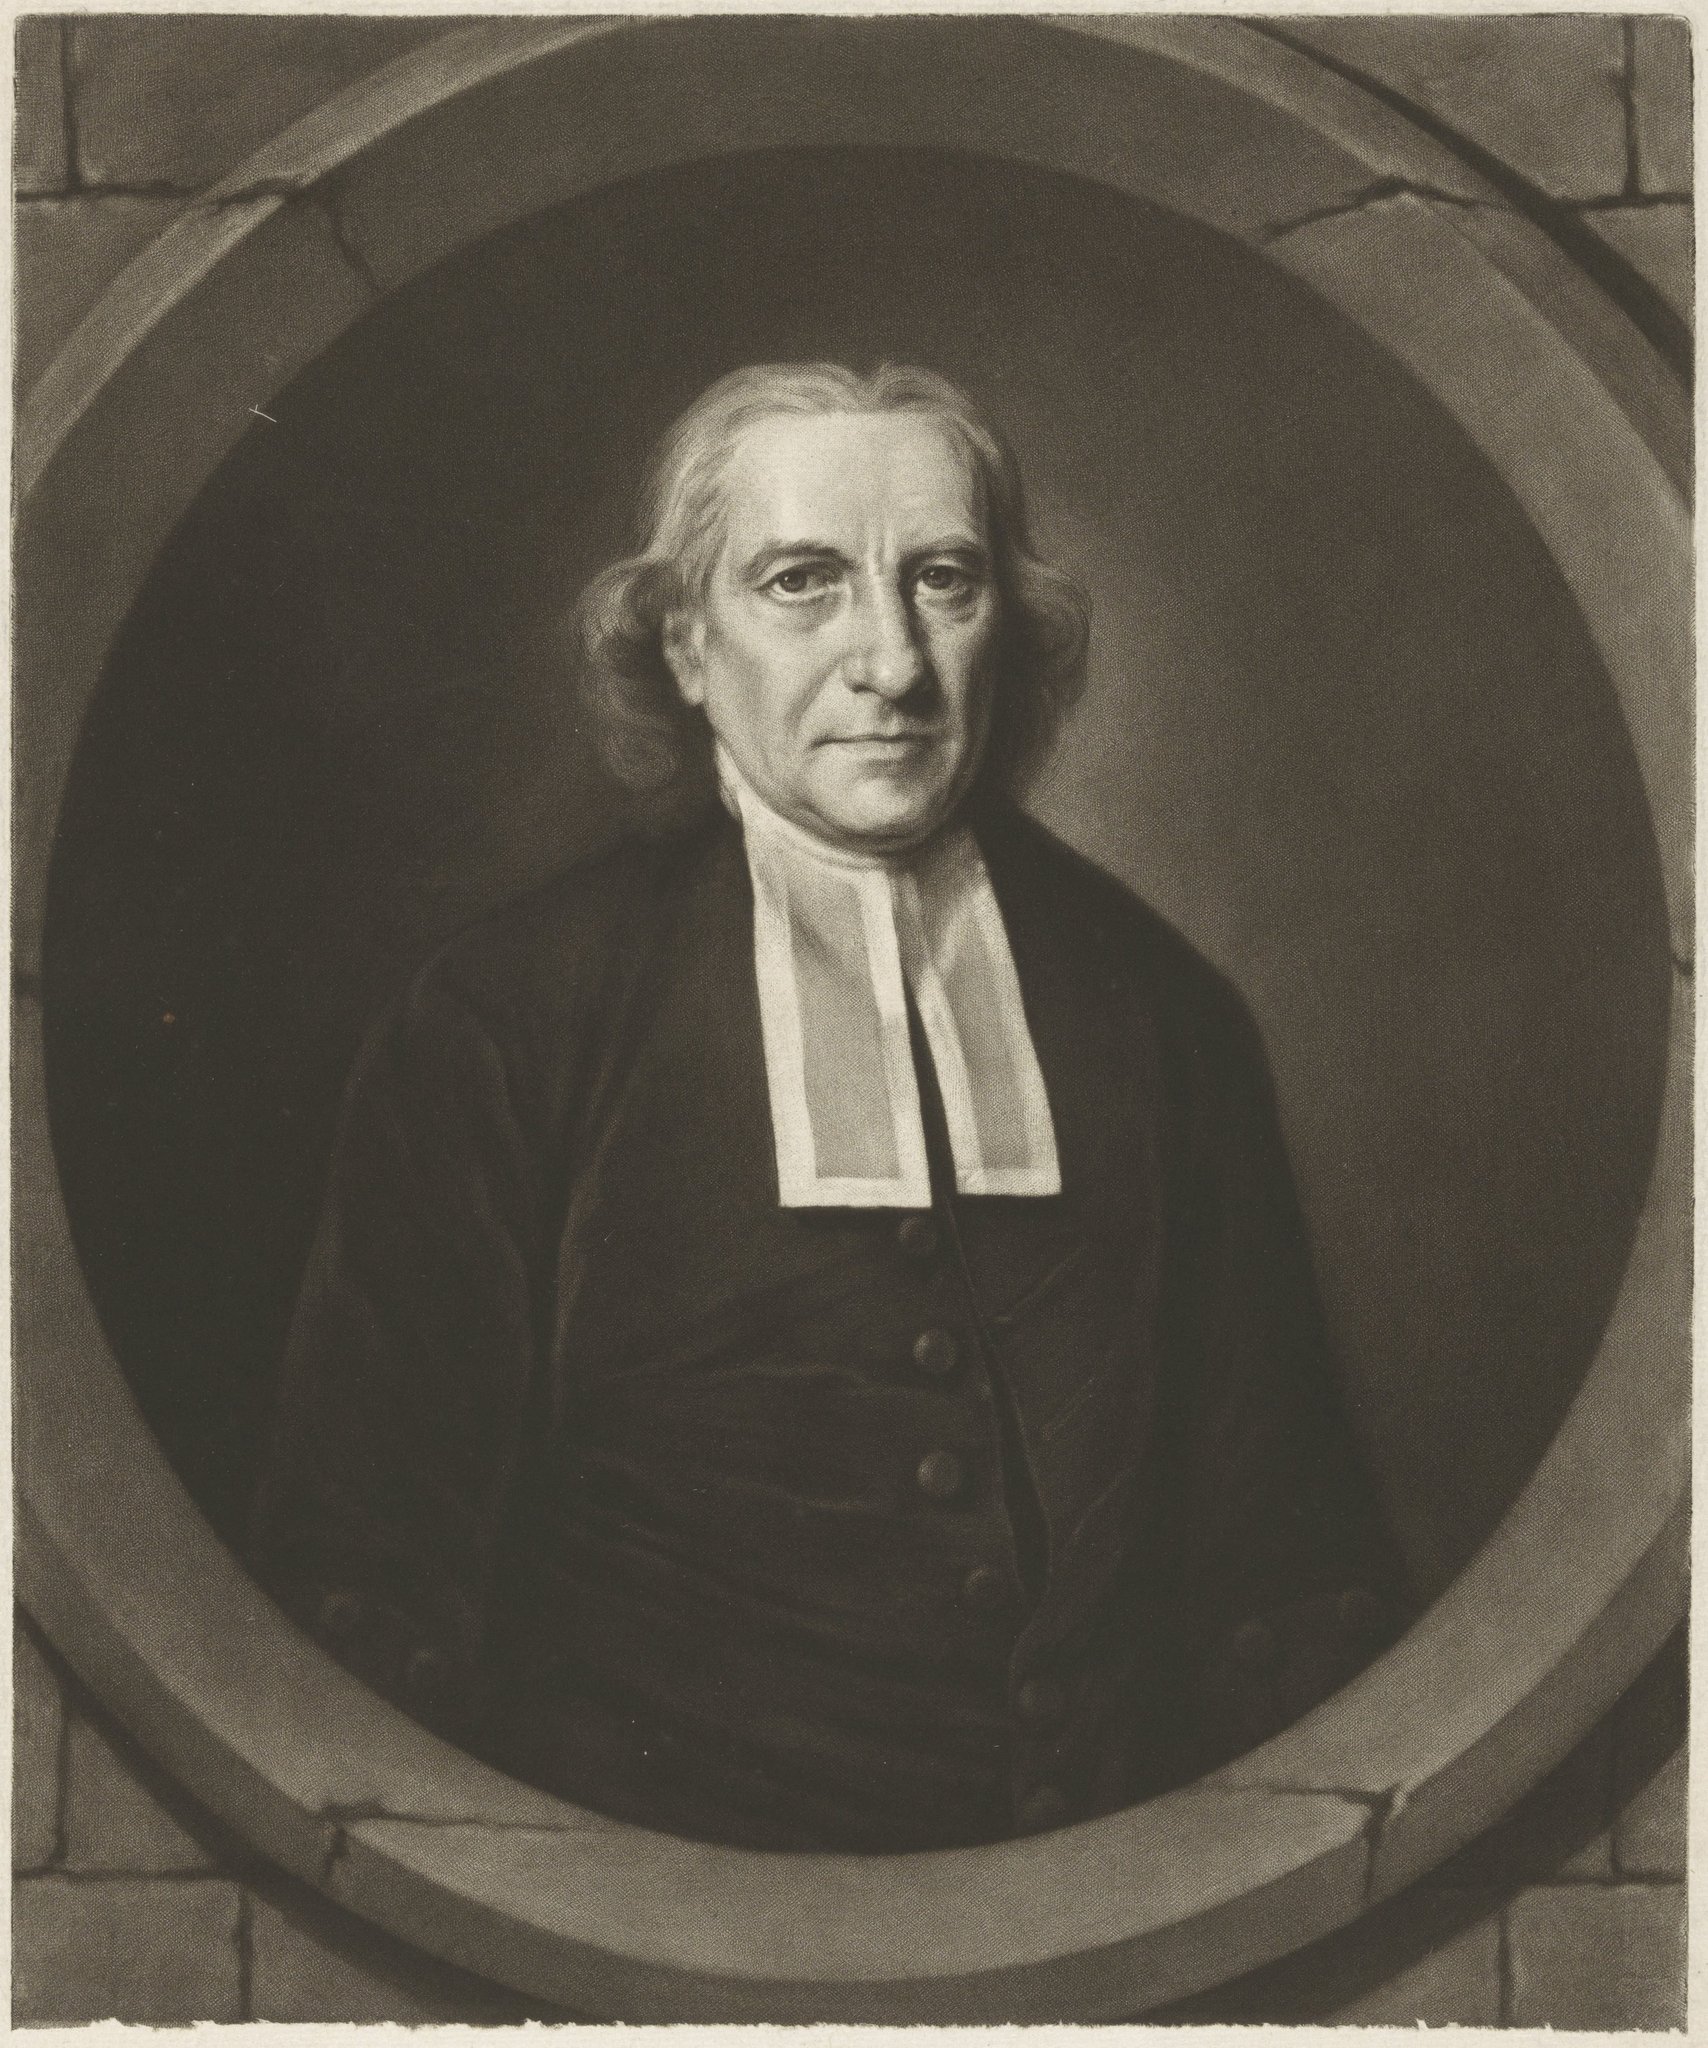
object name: print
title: Portret van een onbekende predikant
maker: Anonymous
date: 1650-1800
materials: paper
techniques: mezzotint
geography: netherlands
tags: functionaries and dignitaries ~ protestant churches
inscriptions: collector's mark: Lugt 240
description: Portret van een onbekende predikant in een ovaal venster.